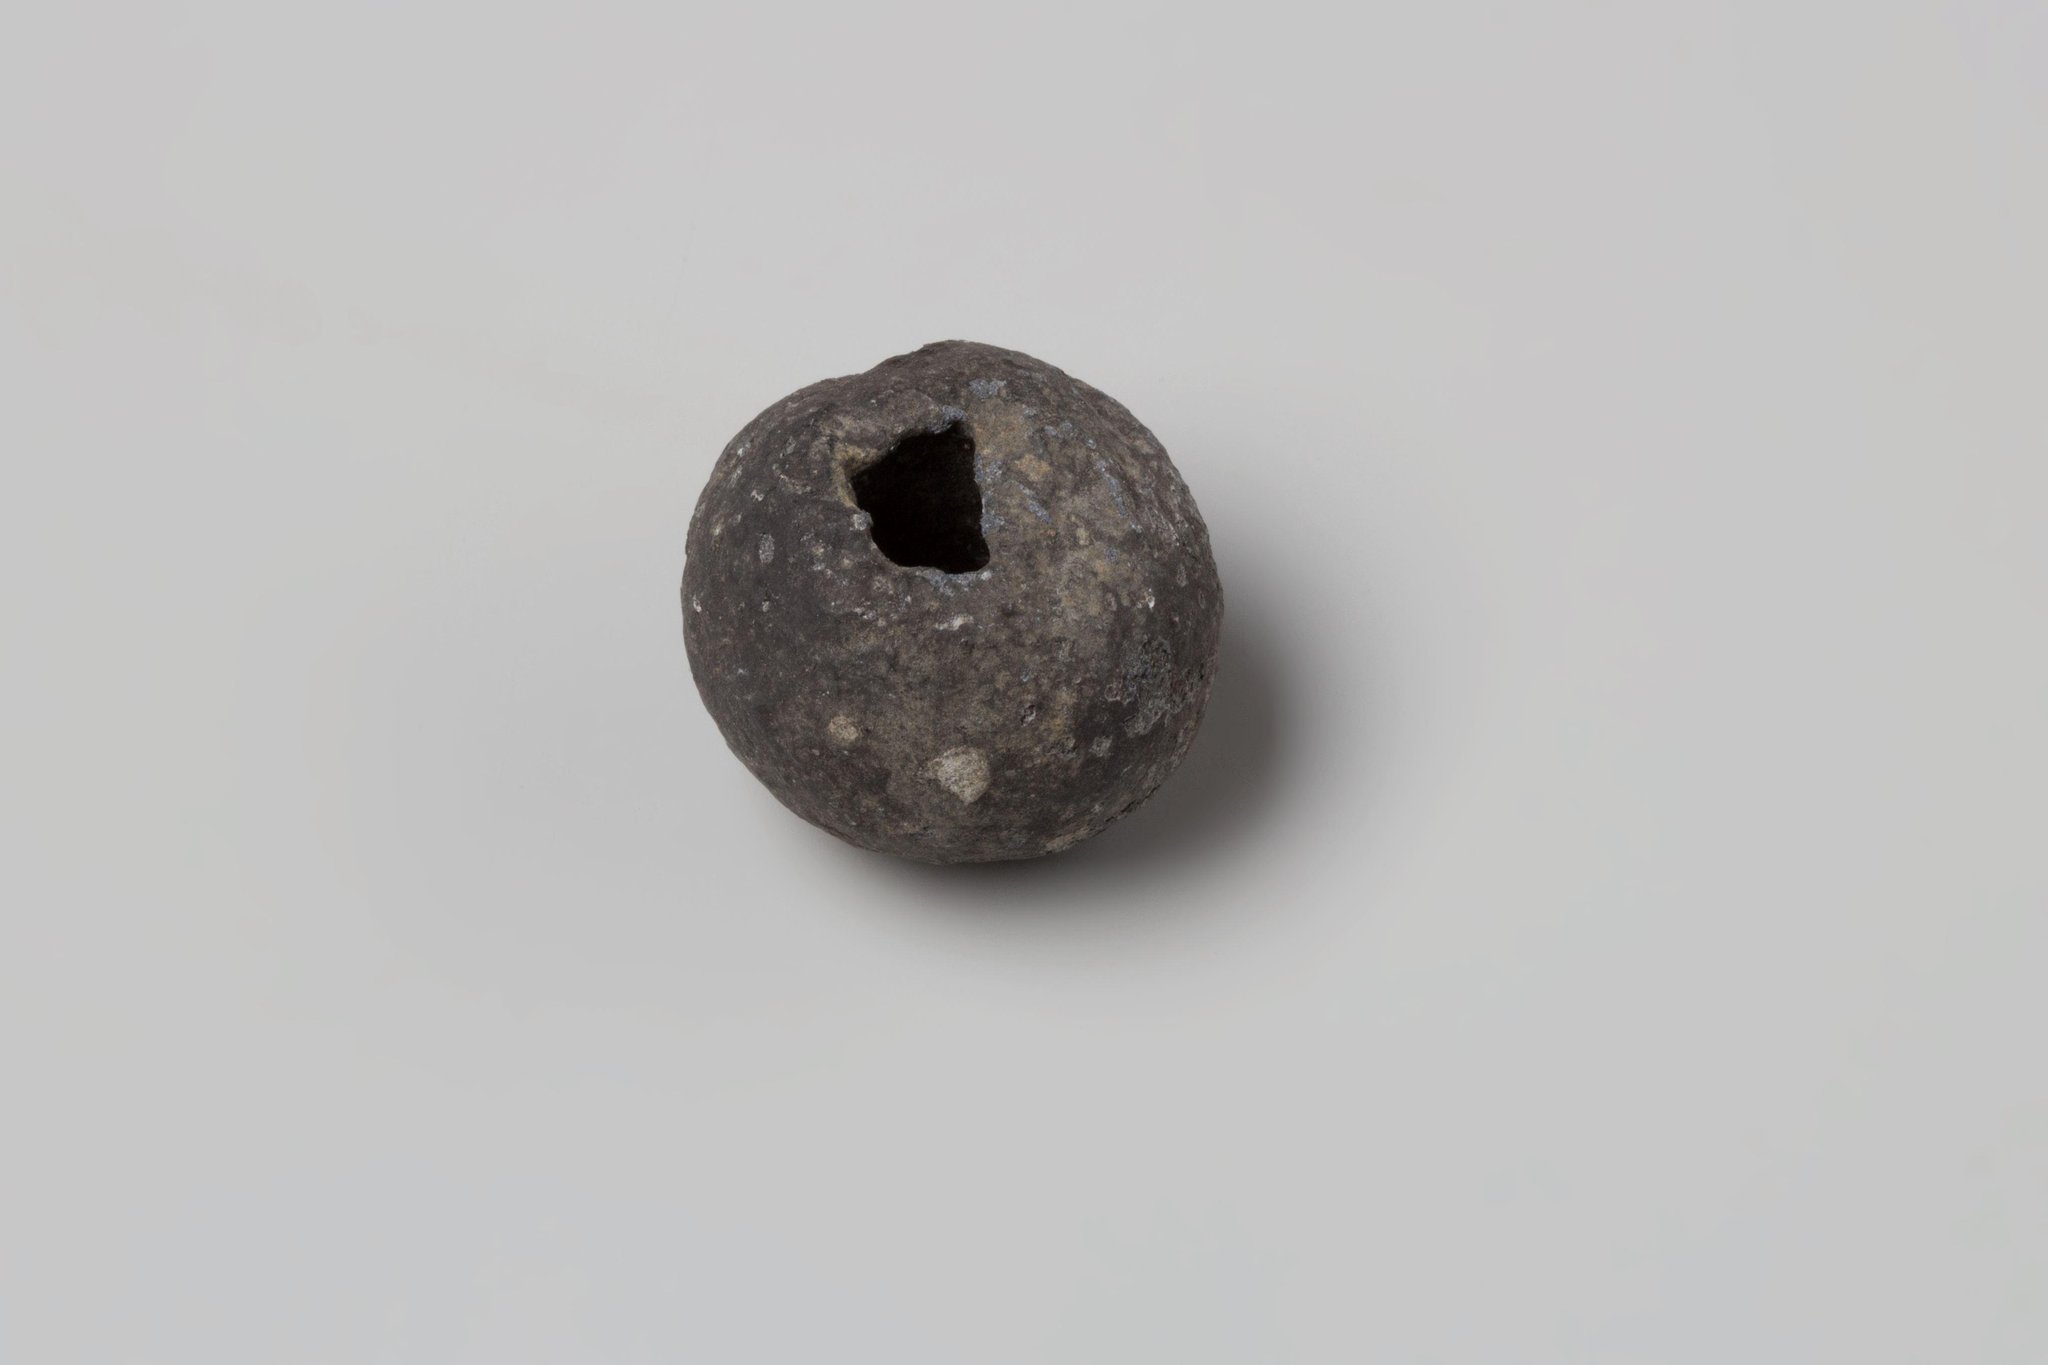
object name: fragment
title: Kogel uit V.O.C.-schip de 'Witte Leeuw'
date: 1613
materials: lead